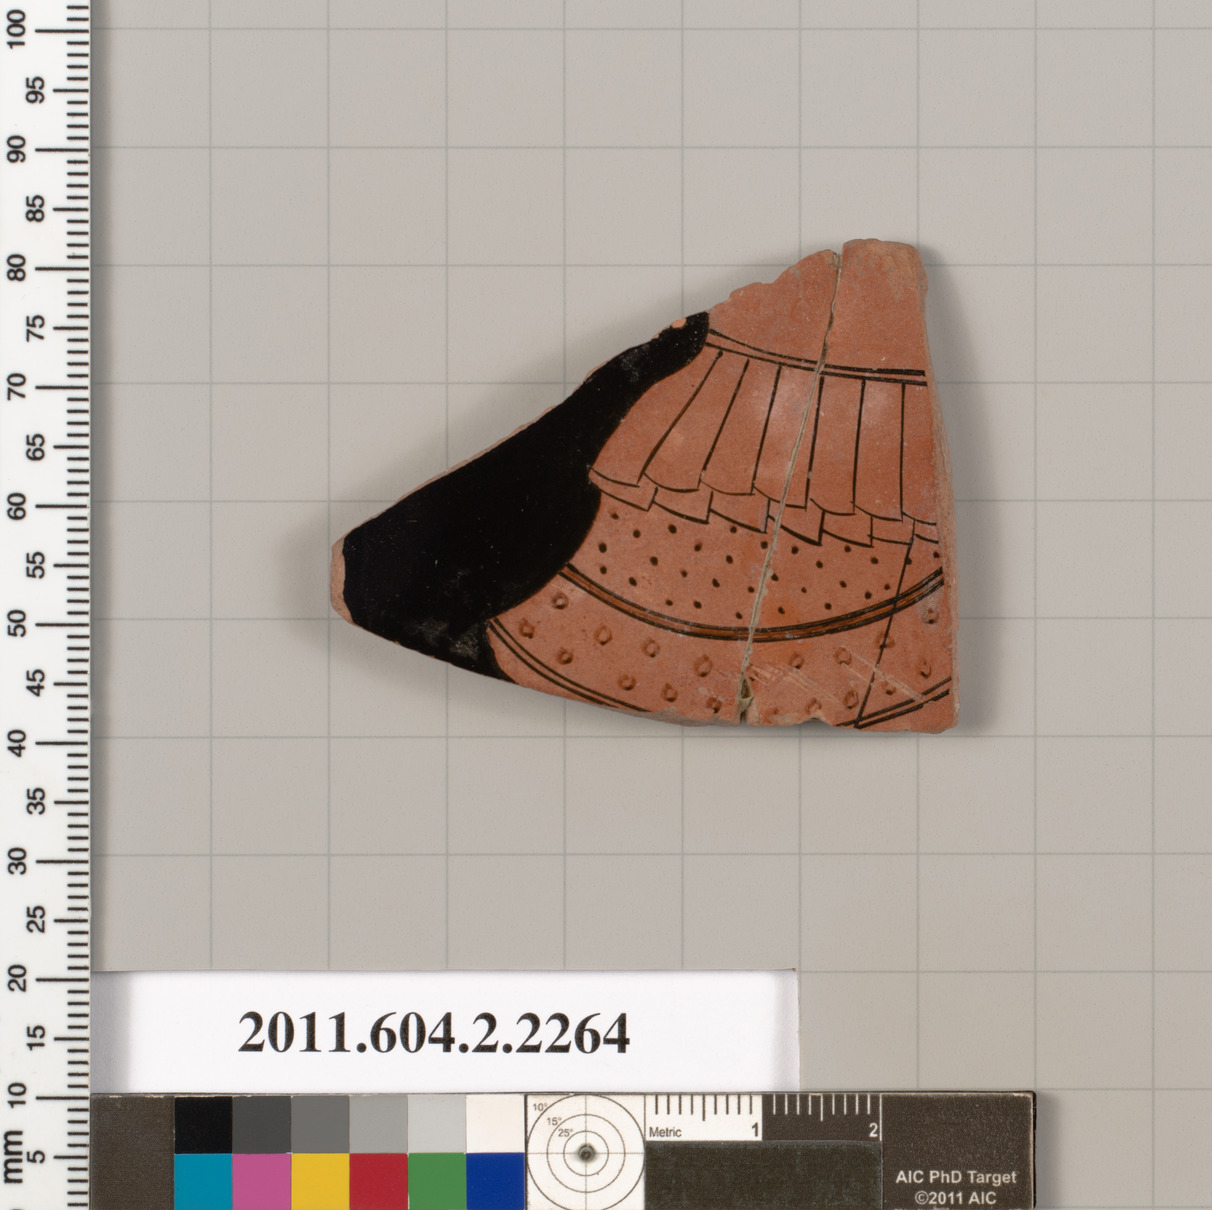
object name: pot fragment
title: Terracotta fragment of a pot; glazed on the inside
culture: greek, attic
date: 475-451 BCE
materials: terracotta